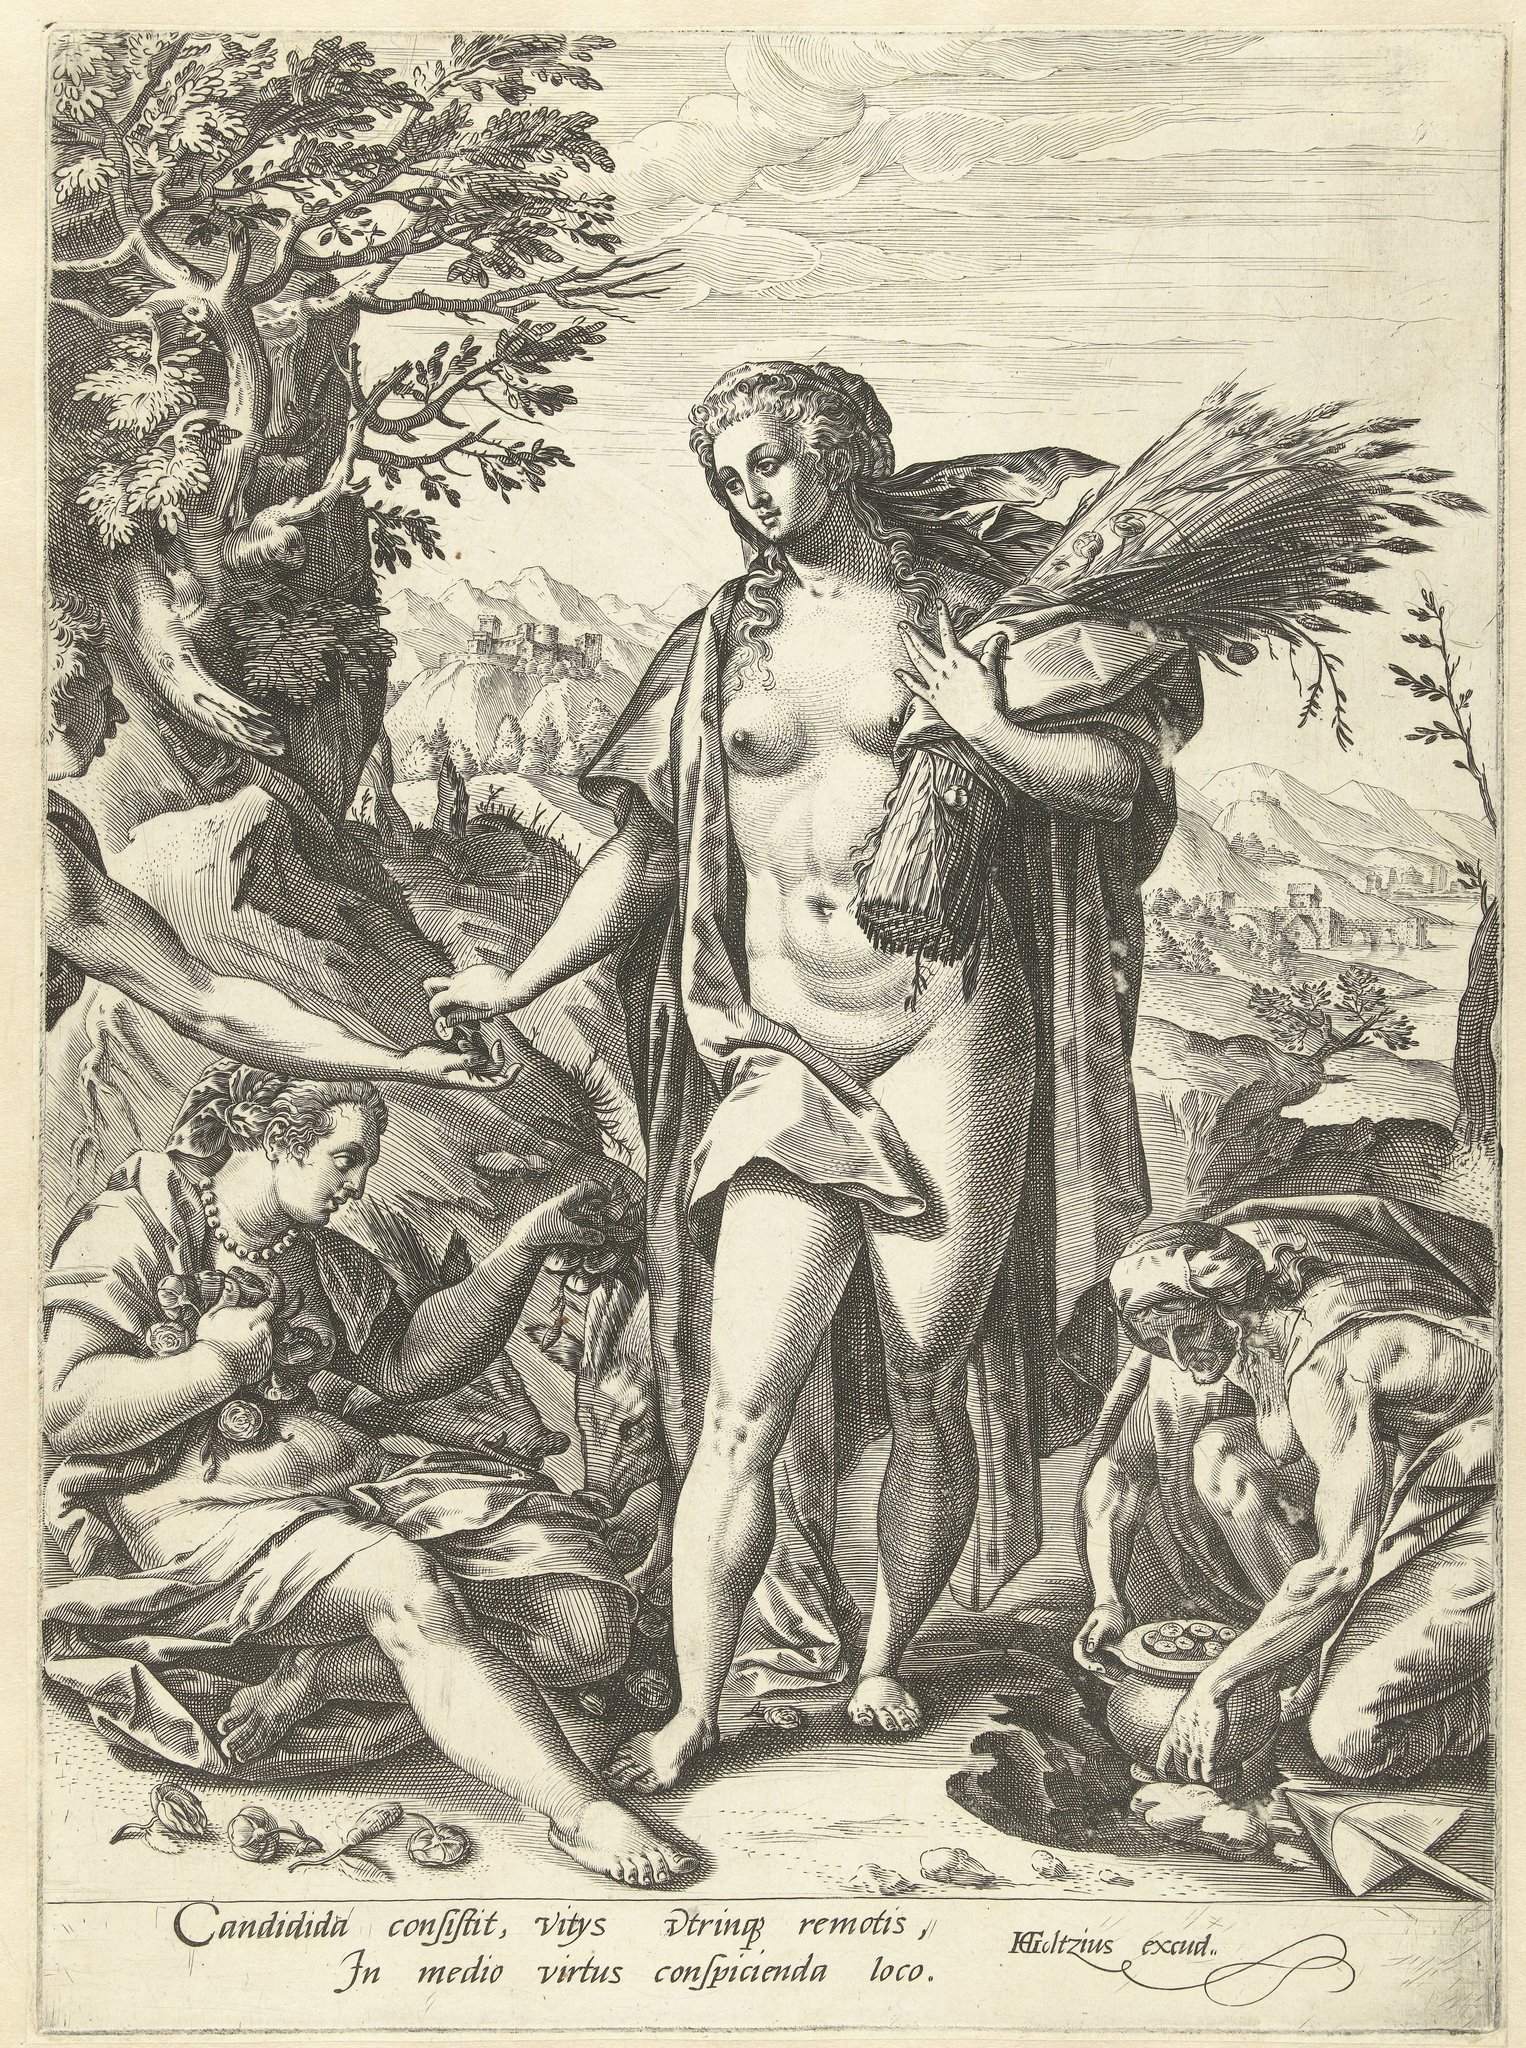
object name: print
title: Allegorie op de naastenliefde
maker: hendrick goltzius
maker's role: draughtsman, painter, print maker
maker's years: 1558-1617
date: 1582-1584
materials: paper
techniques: engraving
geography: haarlem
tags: charity, 'caritas'; 'carità' (ripa) ~ one of the three theological virtues, greed, covetousness, cupidity; 'cupidità' (ripa), generosity, liberality; 'generosità', 'liberalità' (ripa)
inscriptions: collector's mark: Lugt 567, collector's mark: Lugt 2228a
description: Een vrijwel naakte vrouw (naastenliefde) loopt in een kustlandschap, een bundel aren en een tak rozen in de linkerarm, geld weggevend met de rechterhand. Bij haar rechtervoet strooit een mooie jonge vrouw rozen voor een zwijn (vrijgevigheid); bij haar linkervoet begraaft een lelijke oude vrouw een pot met geld (hebzucht). Onder de voorstelling twee regels Latijn.